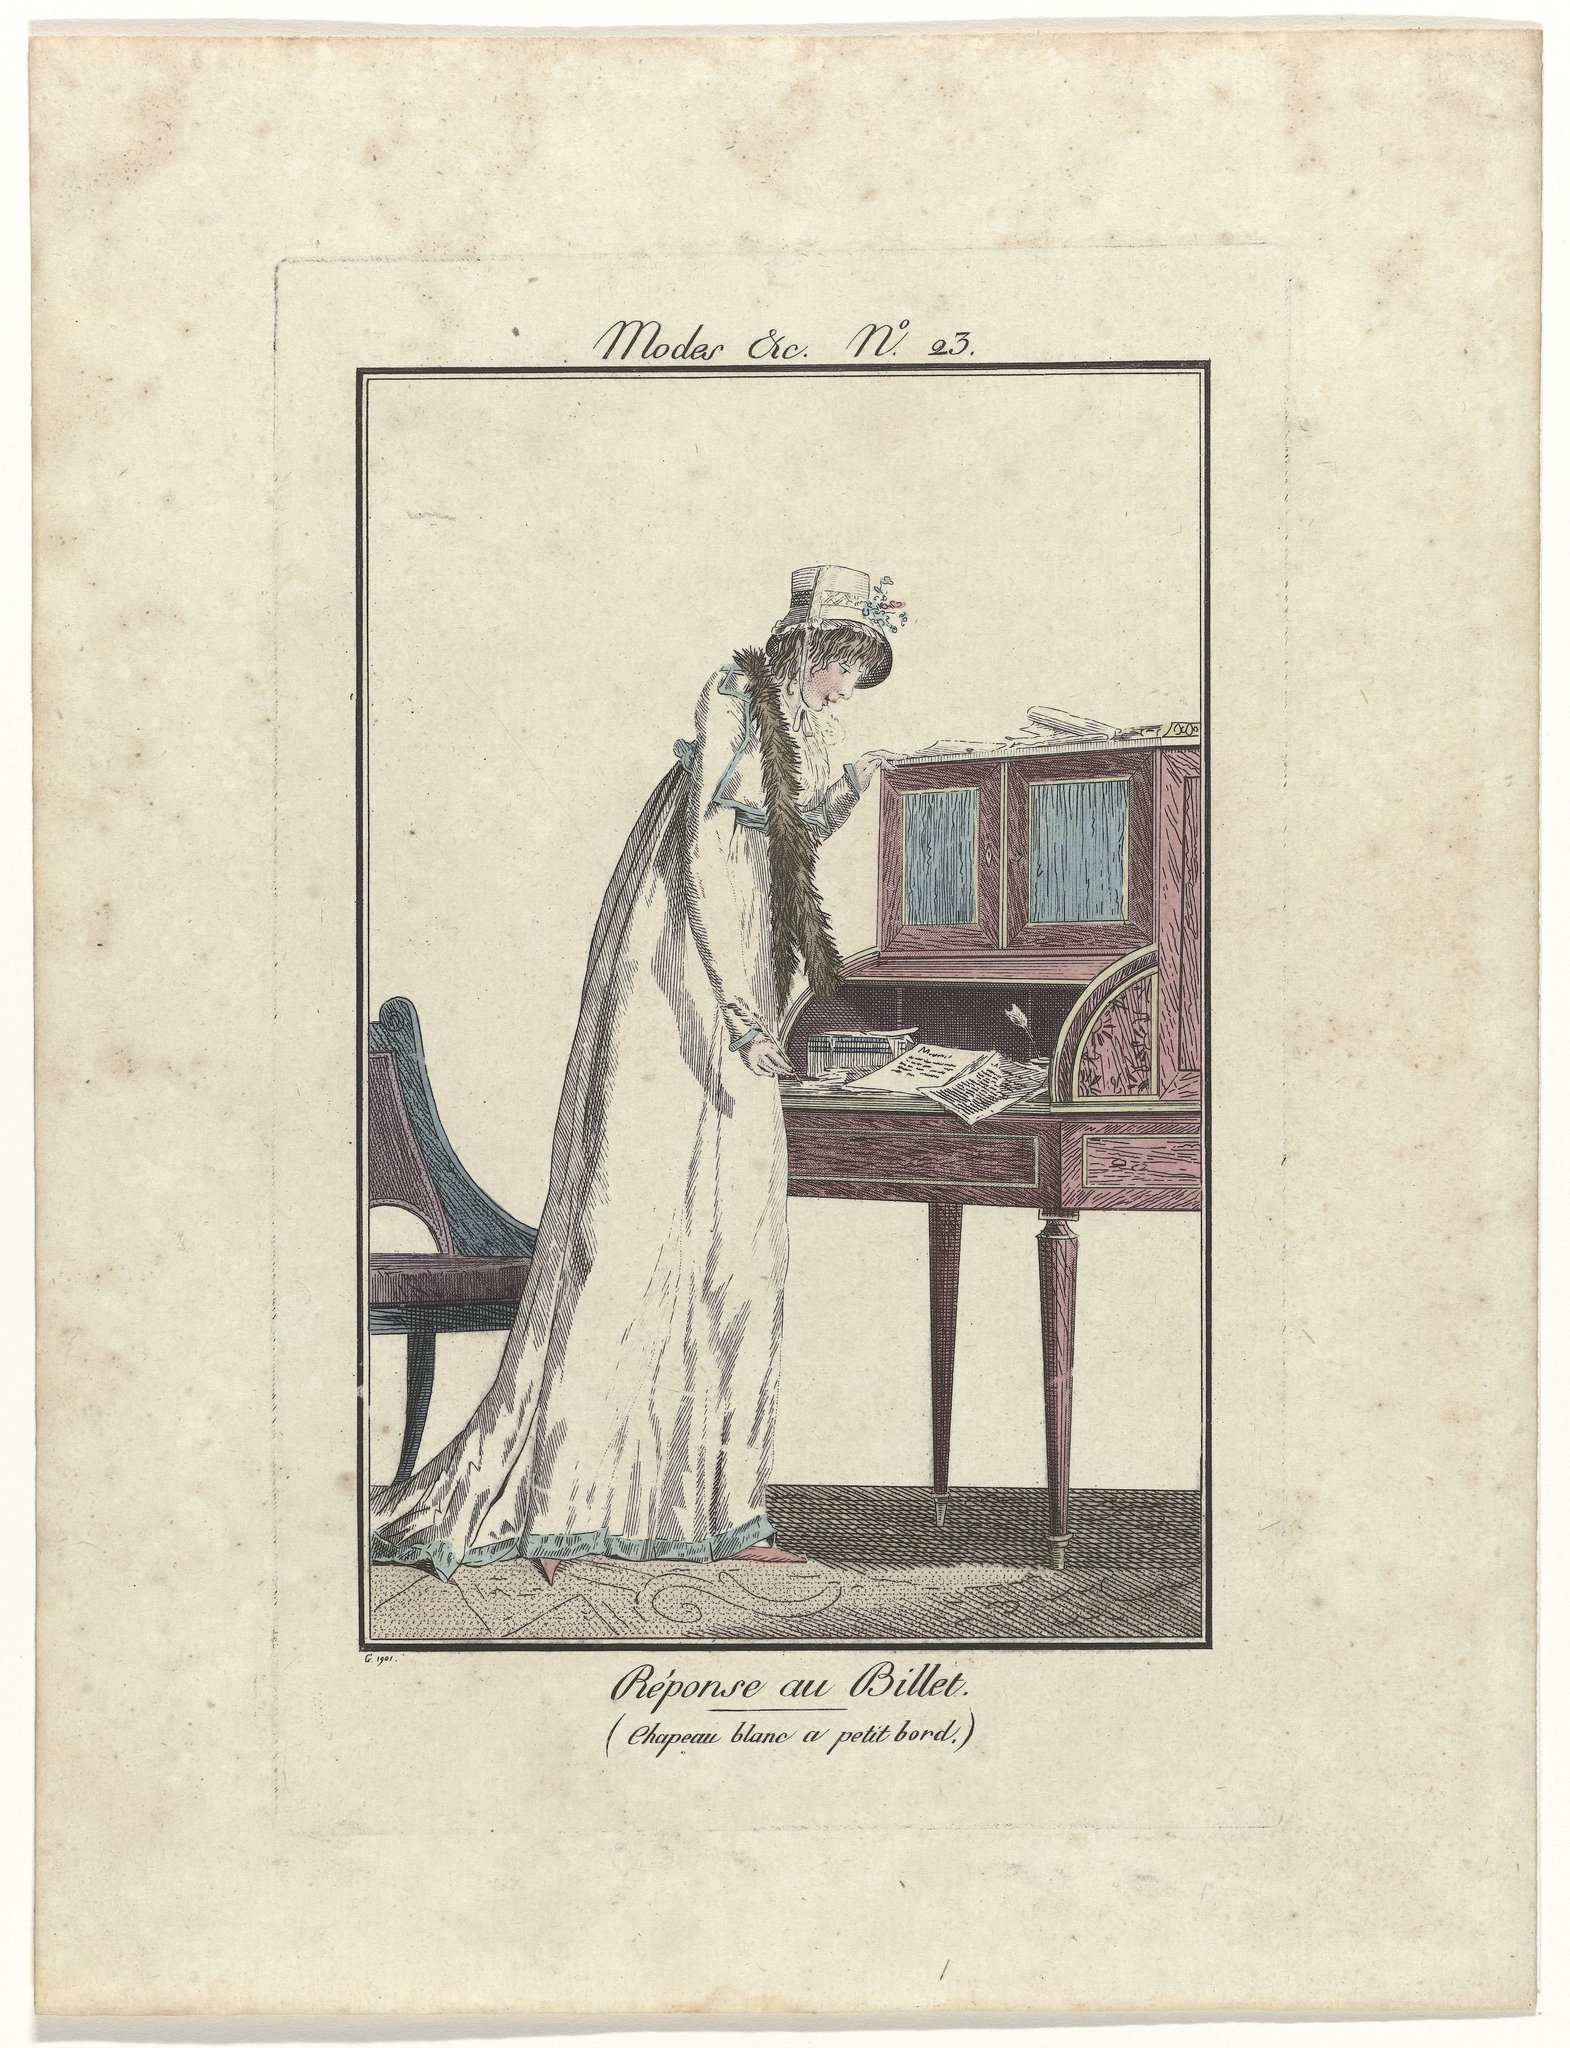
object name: fashion print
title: Modes et Manières du Jour, 1799-1800, No. 23 : Réponse au Billet (...)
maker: pierre de la mésangère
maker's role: publisher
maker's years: 1761-1831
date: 1912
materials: paper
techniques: etching, hand coloring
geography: paris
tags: writing-table, writing-desk, clothing for the upper part of the body (+ women's clothes), neck-gear ~ clothing (palatine) (+ women's clothes), clothing for the upper part of the body (spencer) (+ women's clothes), fashion plates, head-gear: hat (+ women's clothes), shoes, sandals (+ women's clothes), dress, gown (+ women's clothes), materials to write on, writing surfaces, chair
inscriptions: caption: ‘Réponse au Billet. / (Chapeau blanc a petit bord.)’, title: ‘Modes & c. No. 23.’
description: Vrouw, staande bij een open secretaire waarop enkele papieren liggen, met schrijfveer in de hand. Zij draagt een spencer op een japon met sleep, beide afgezet met een gekleurde bies. Op het hoofd een witte hoed met smalle boord. Om de hals een 'palatine'. platte schoenen met puntige neuzen. De prent is een kopie door Gosselin naar No. 23 uit de serie 'Modes et manières du jour', uitgegeven door Pierre de la Mésangère, Parijs, 1799-1808.